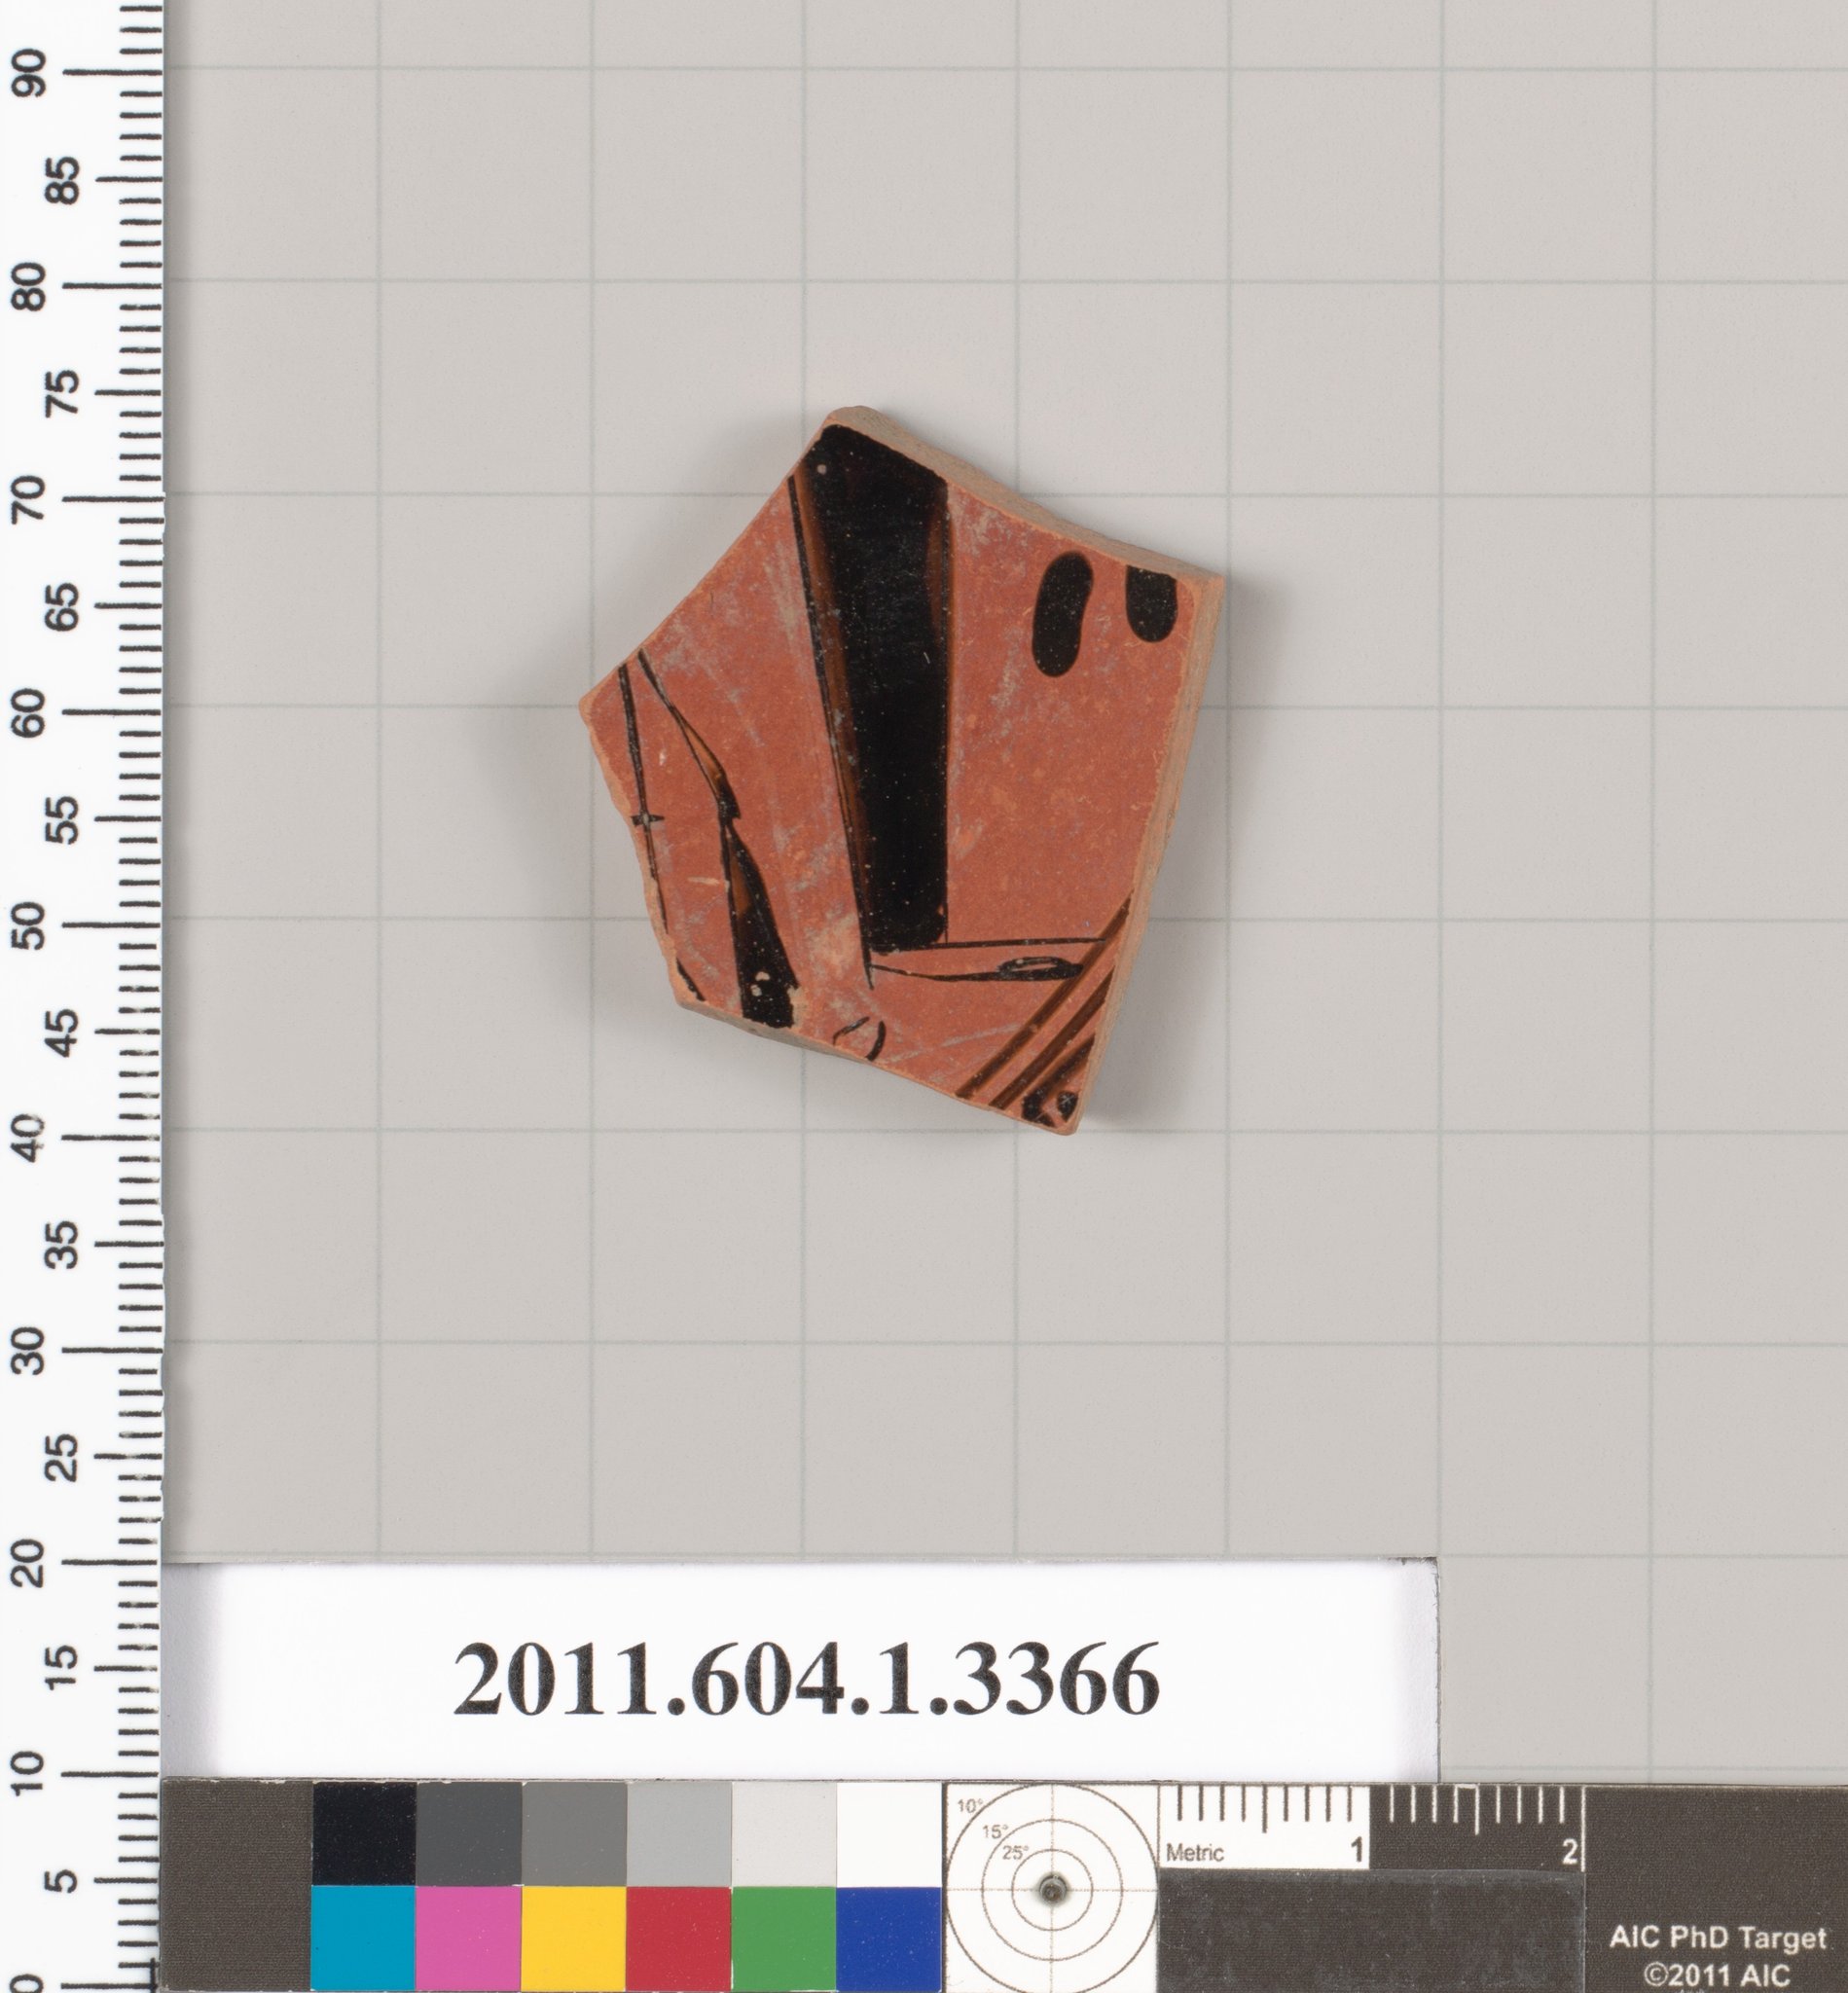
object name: kylix fragment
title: Terracotta fragment of a kylix (drinking cup)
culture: greek, attic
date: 475-451 BCE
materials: terracotta